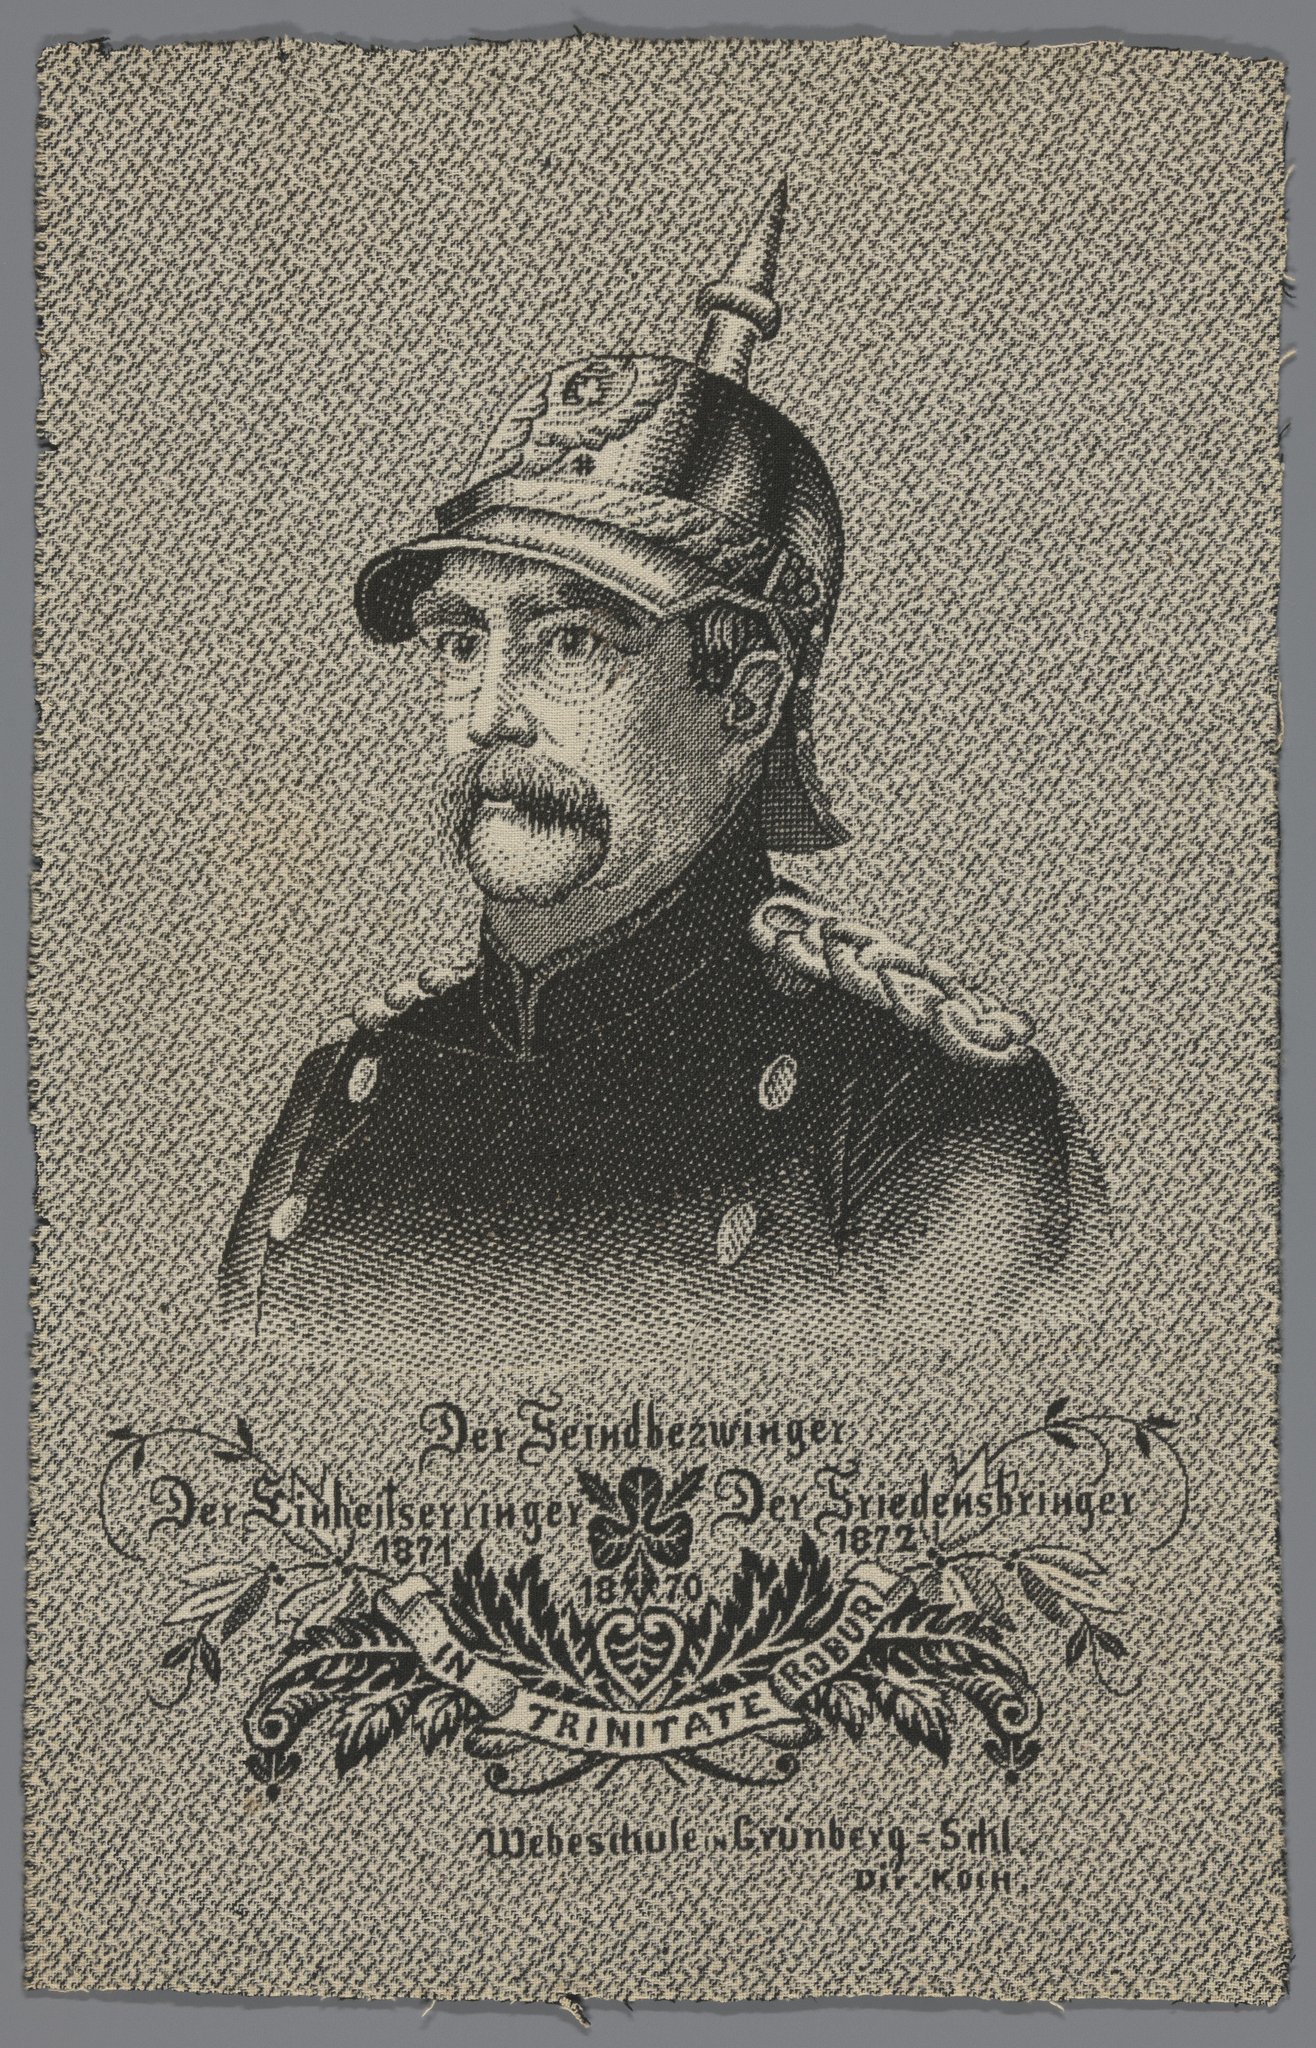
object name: woven material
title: Portret van Otto von Bismarck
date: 1872-1880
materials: textile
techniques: weave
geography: zielona góra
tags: historical persons, germany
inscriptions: inscription: ‘Der Feindbezwinger/ Der Einheitserringer/ Der Friedensbringer/ 1871/ 1870/ 1872/ In Trinitate Robur/ Webeschule in Grünberg-Schl./ Dir. Koch.’